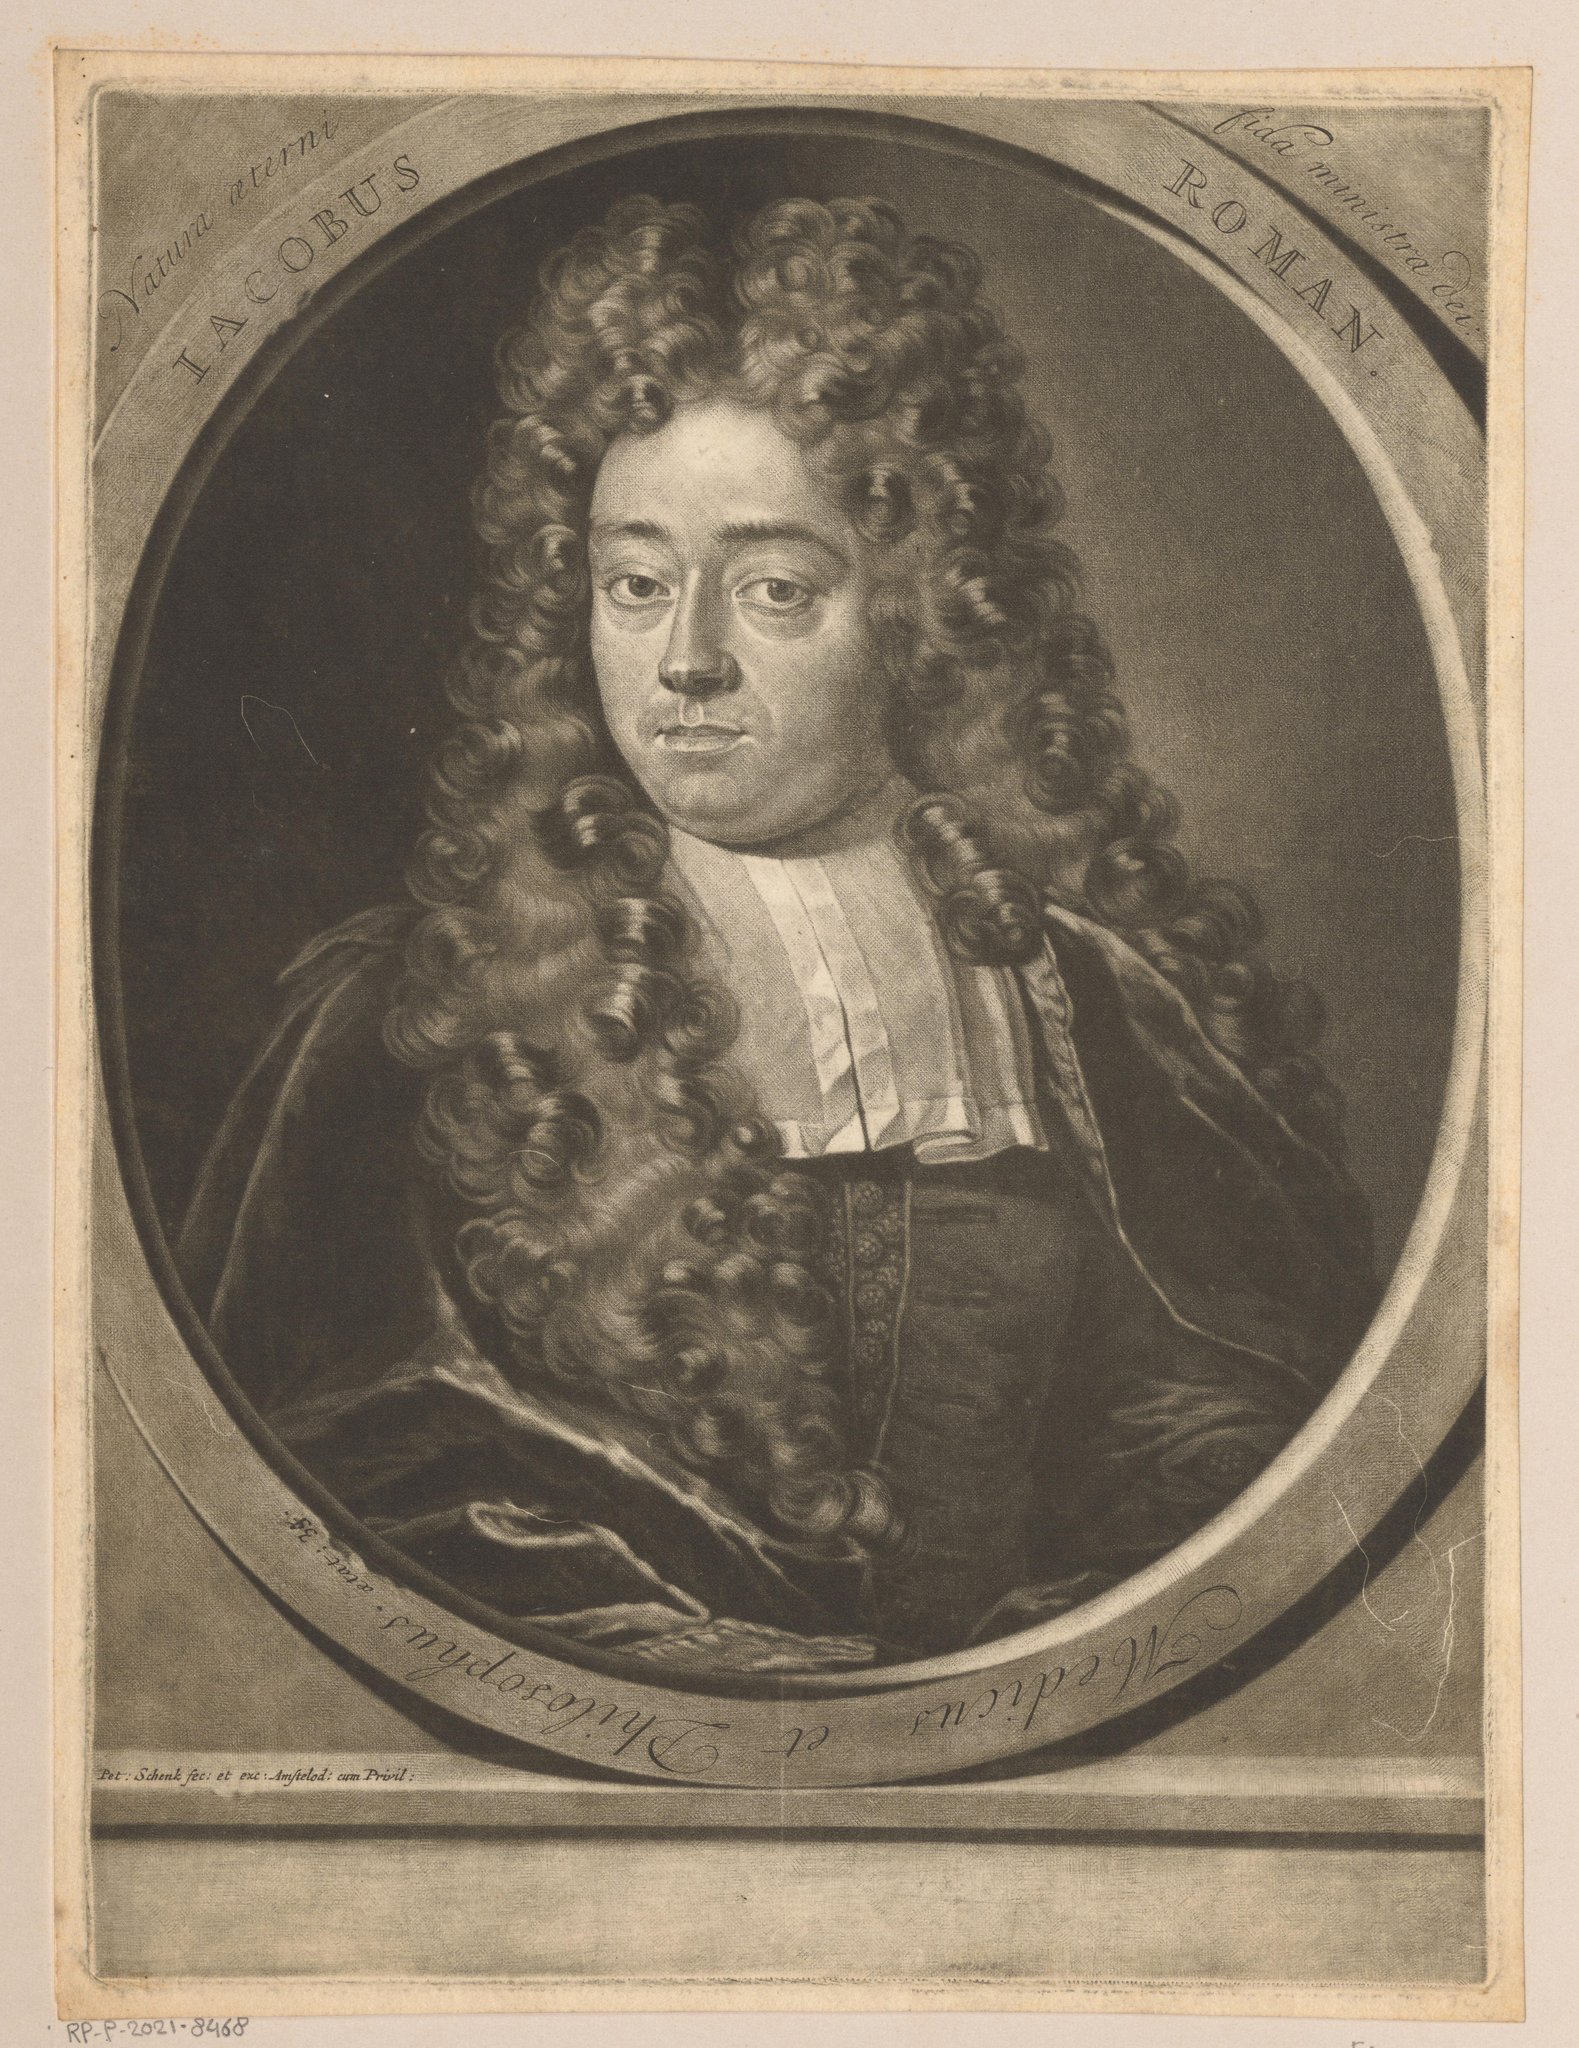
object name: print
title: Portret van Jacob Roman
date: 1675-1711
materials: paper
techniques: engraving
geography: amsterdam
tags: historical persons